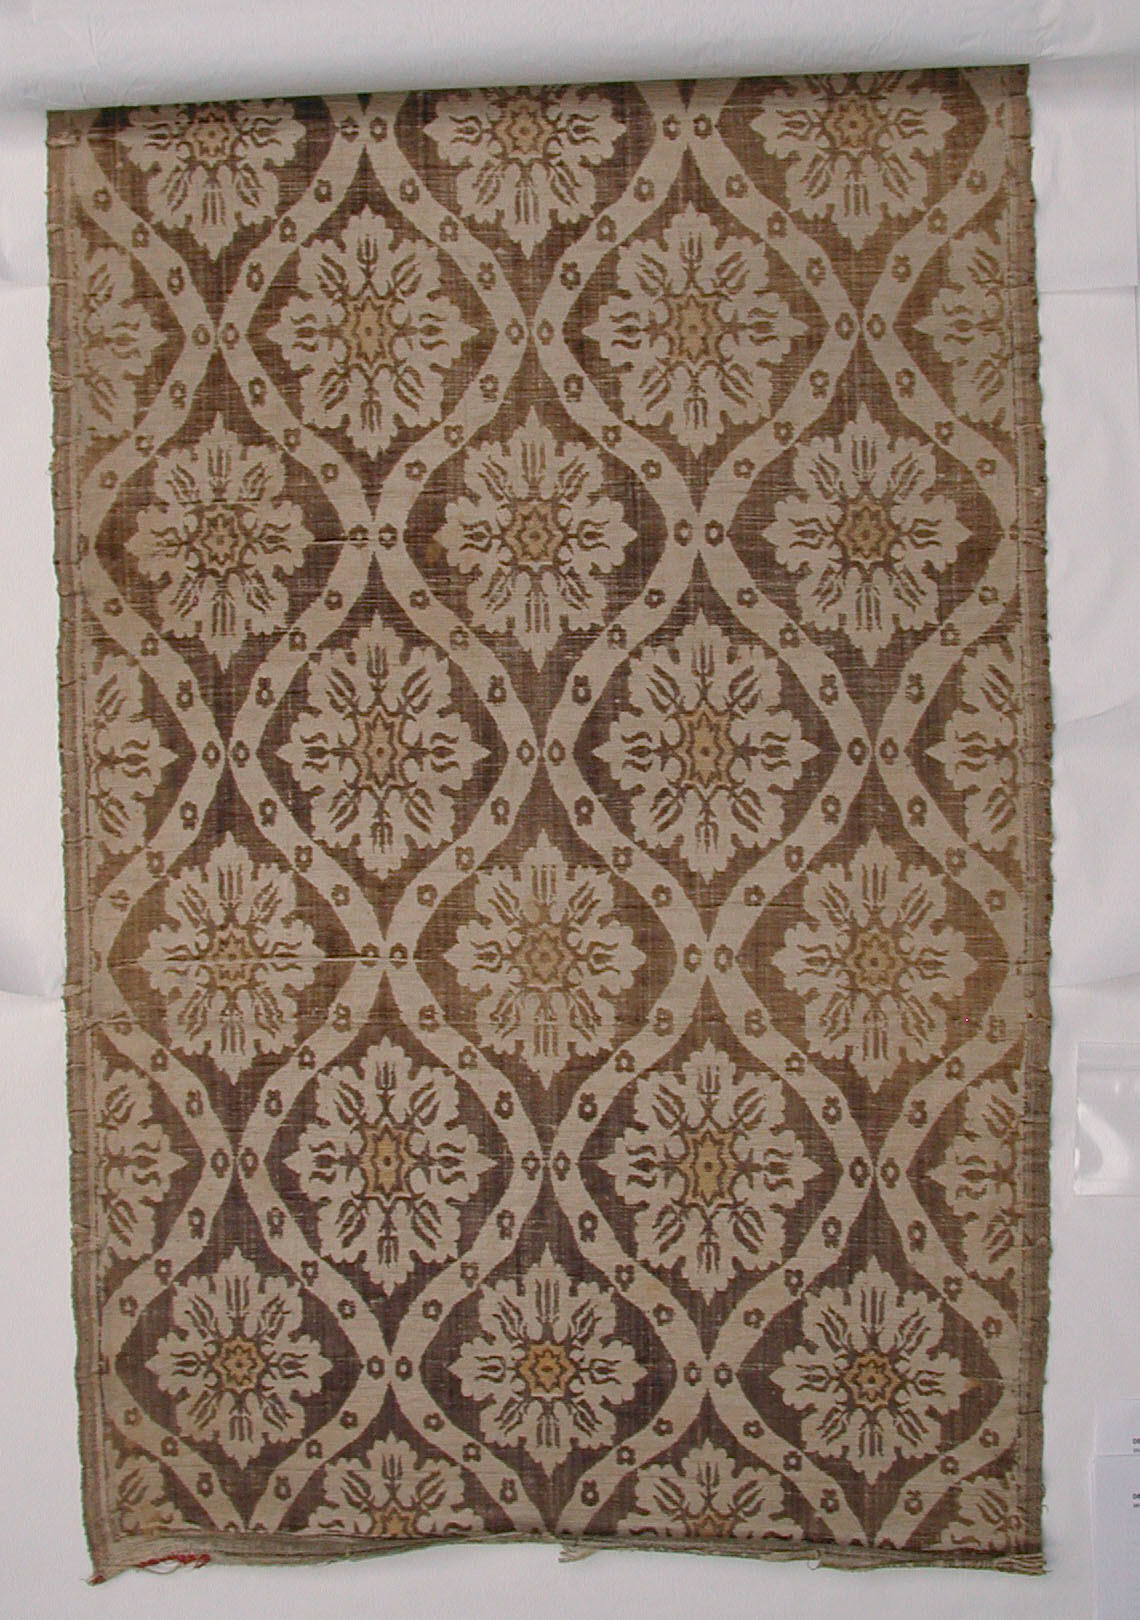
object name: brocade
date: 1601-1700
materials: cotton, silk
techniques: brocade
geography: turkey